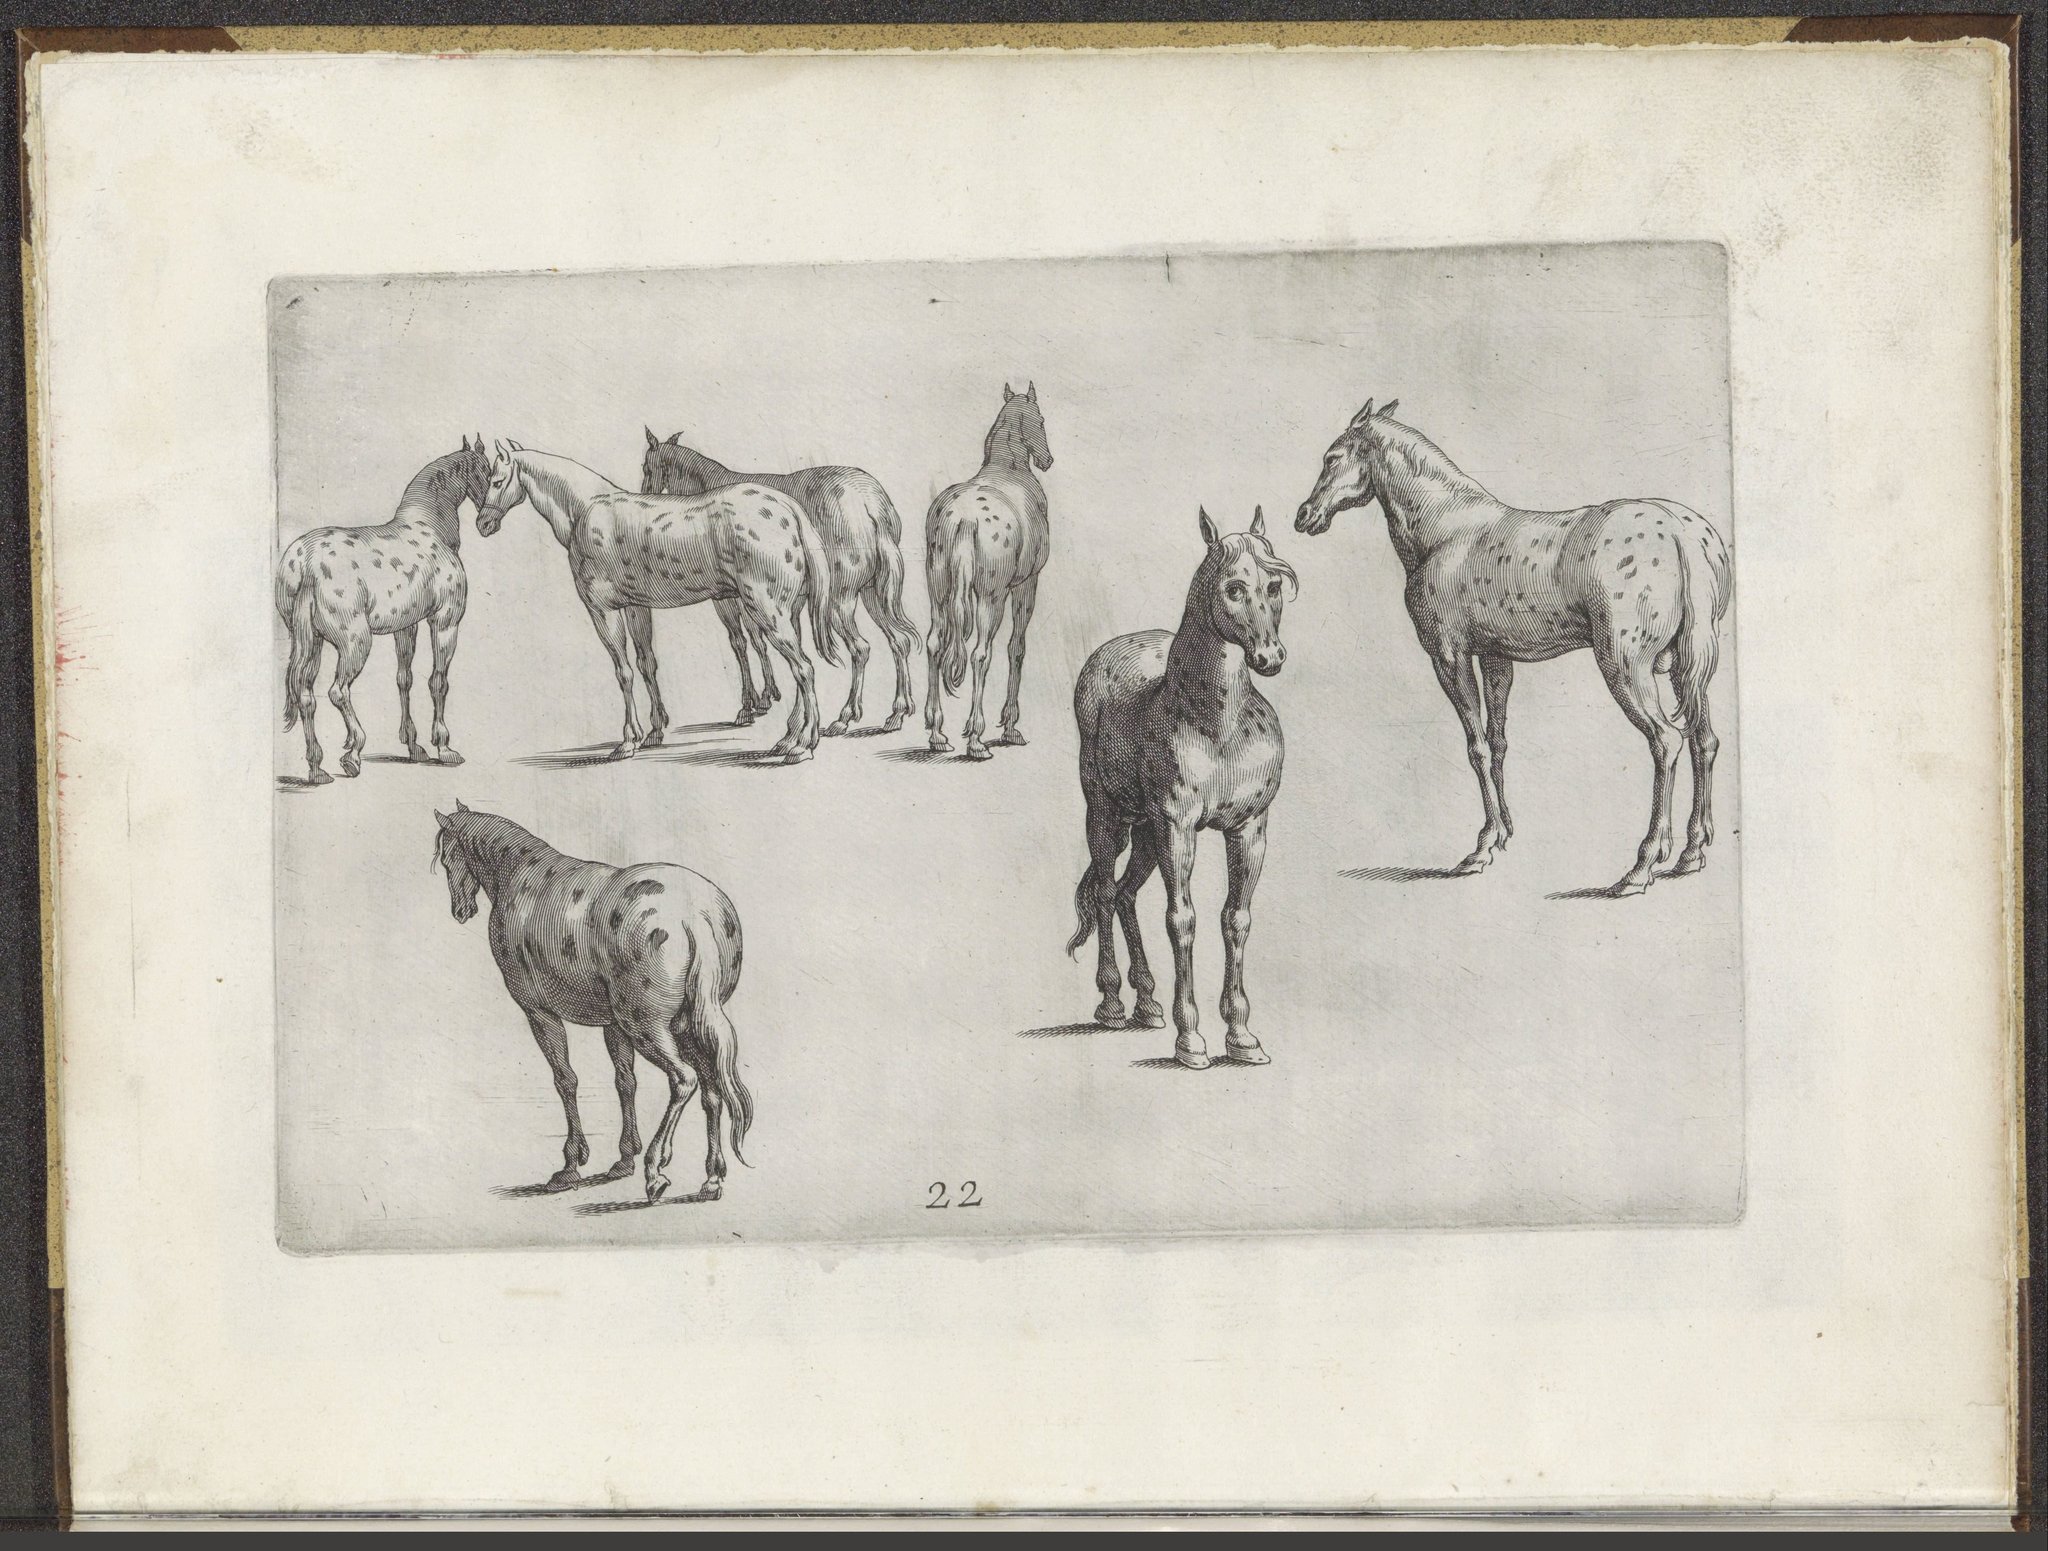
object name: print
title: Tekenvoorbeelden van paarden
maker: pieter de jode (i)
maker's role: draughtsman, print maker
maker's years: 1570-1634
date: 1629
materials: paper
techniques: engraving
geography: antwerp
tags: horse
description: Tekenvoorbeelden van zeven paarden (appelschimmels) vanuit verschillende hoeken gezien. Deze prent maakt deel uit van een album.